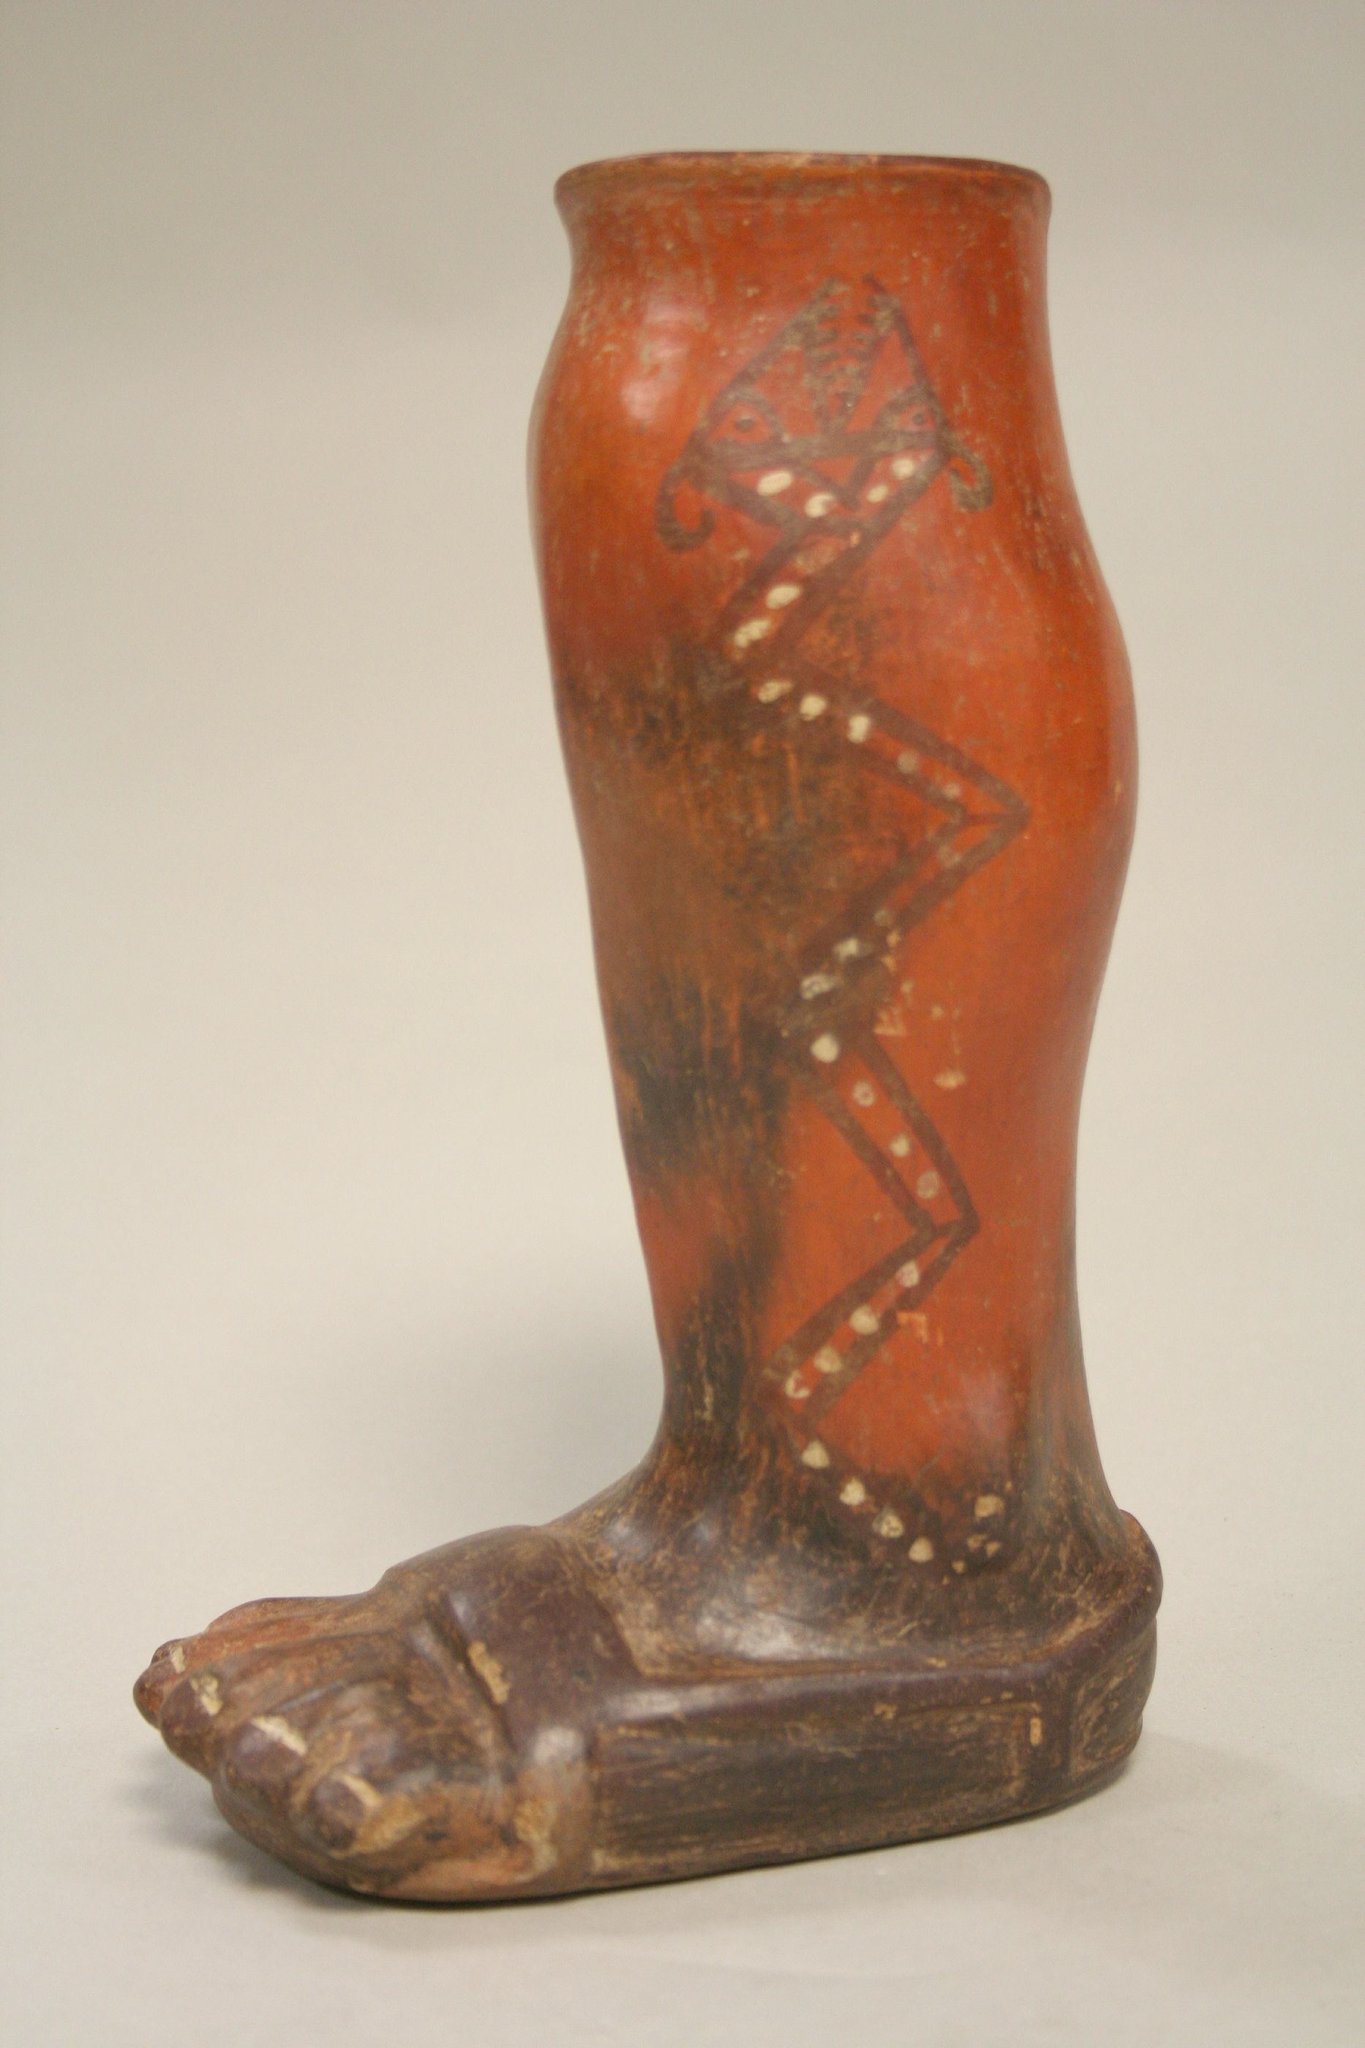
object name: vessel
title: Vessel, Leg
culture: inca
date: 1401-1600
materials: ceramic, pigment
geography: peru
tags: legs